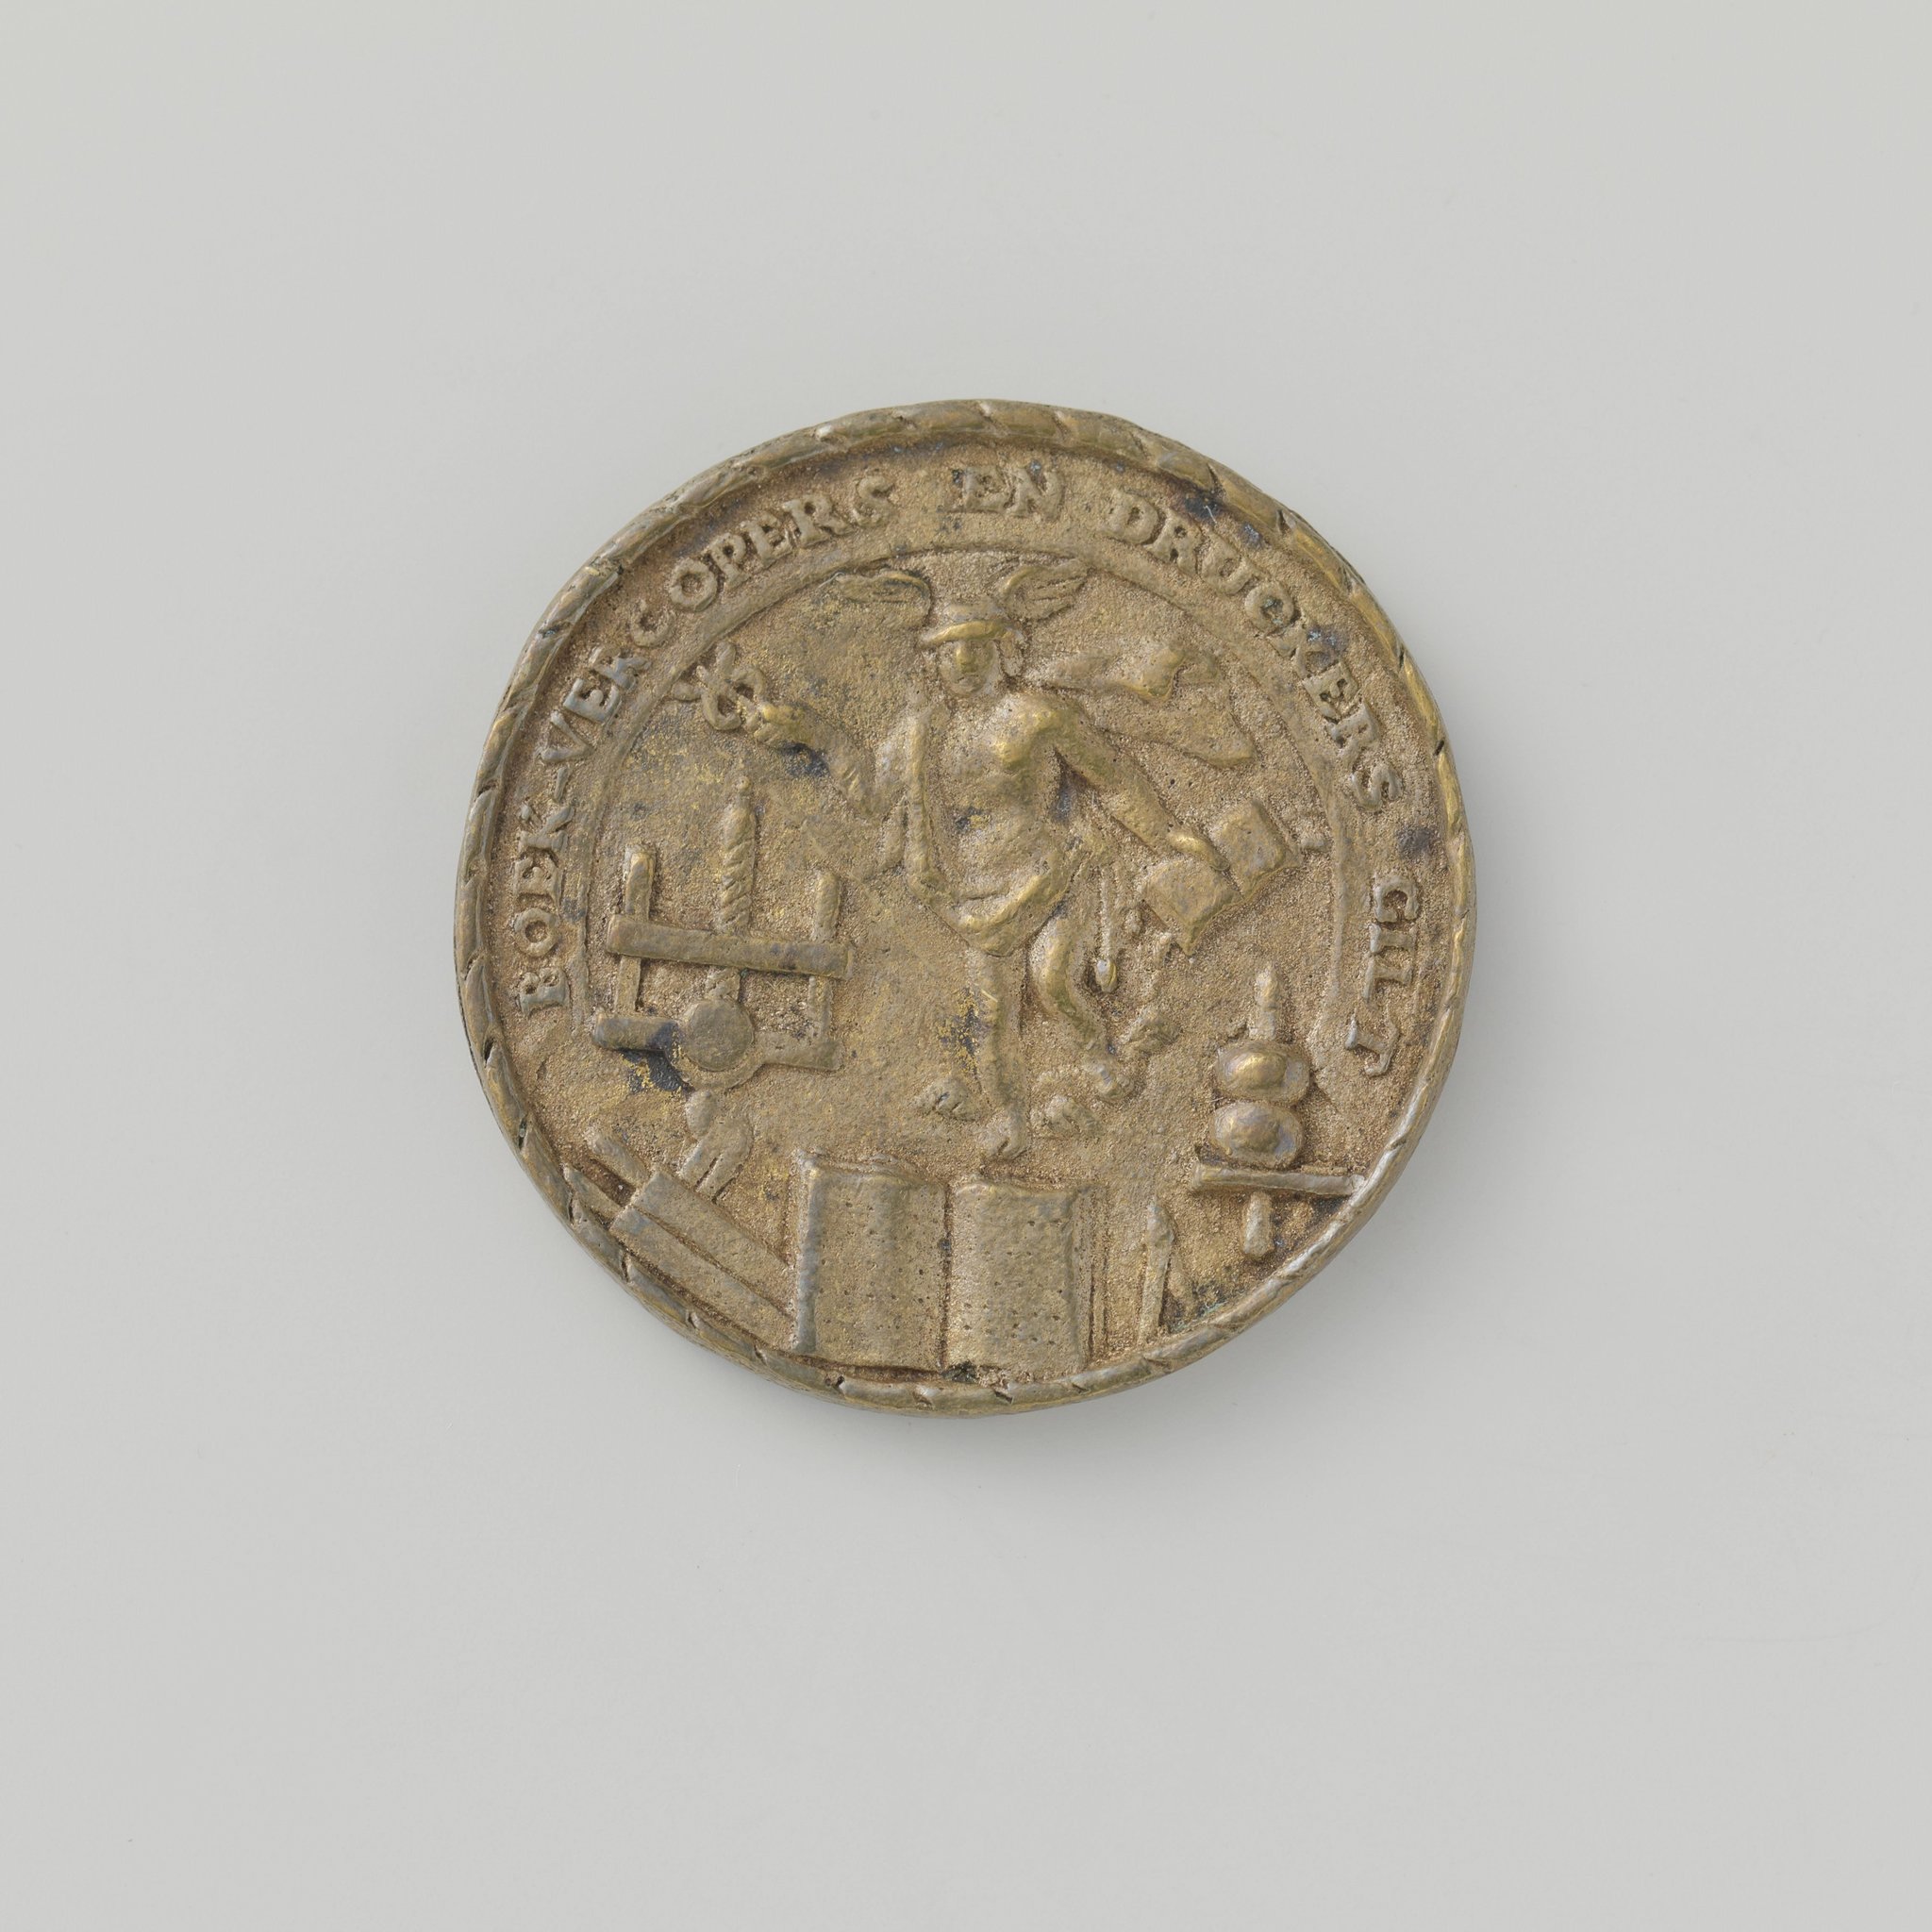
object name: medal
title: Book Printers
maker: Anonymous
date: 1631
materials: brass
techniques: casting, engraving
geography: middelburg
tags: haarlem, publisher, zacharias roman, middelburg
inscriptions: inscription: ‘BOEK-VERCOPERS EN DRUCKERS GILT’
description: Guild medals Members of trade guilds had to identify themselves with a medal at their meetings.